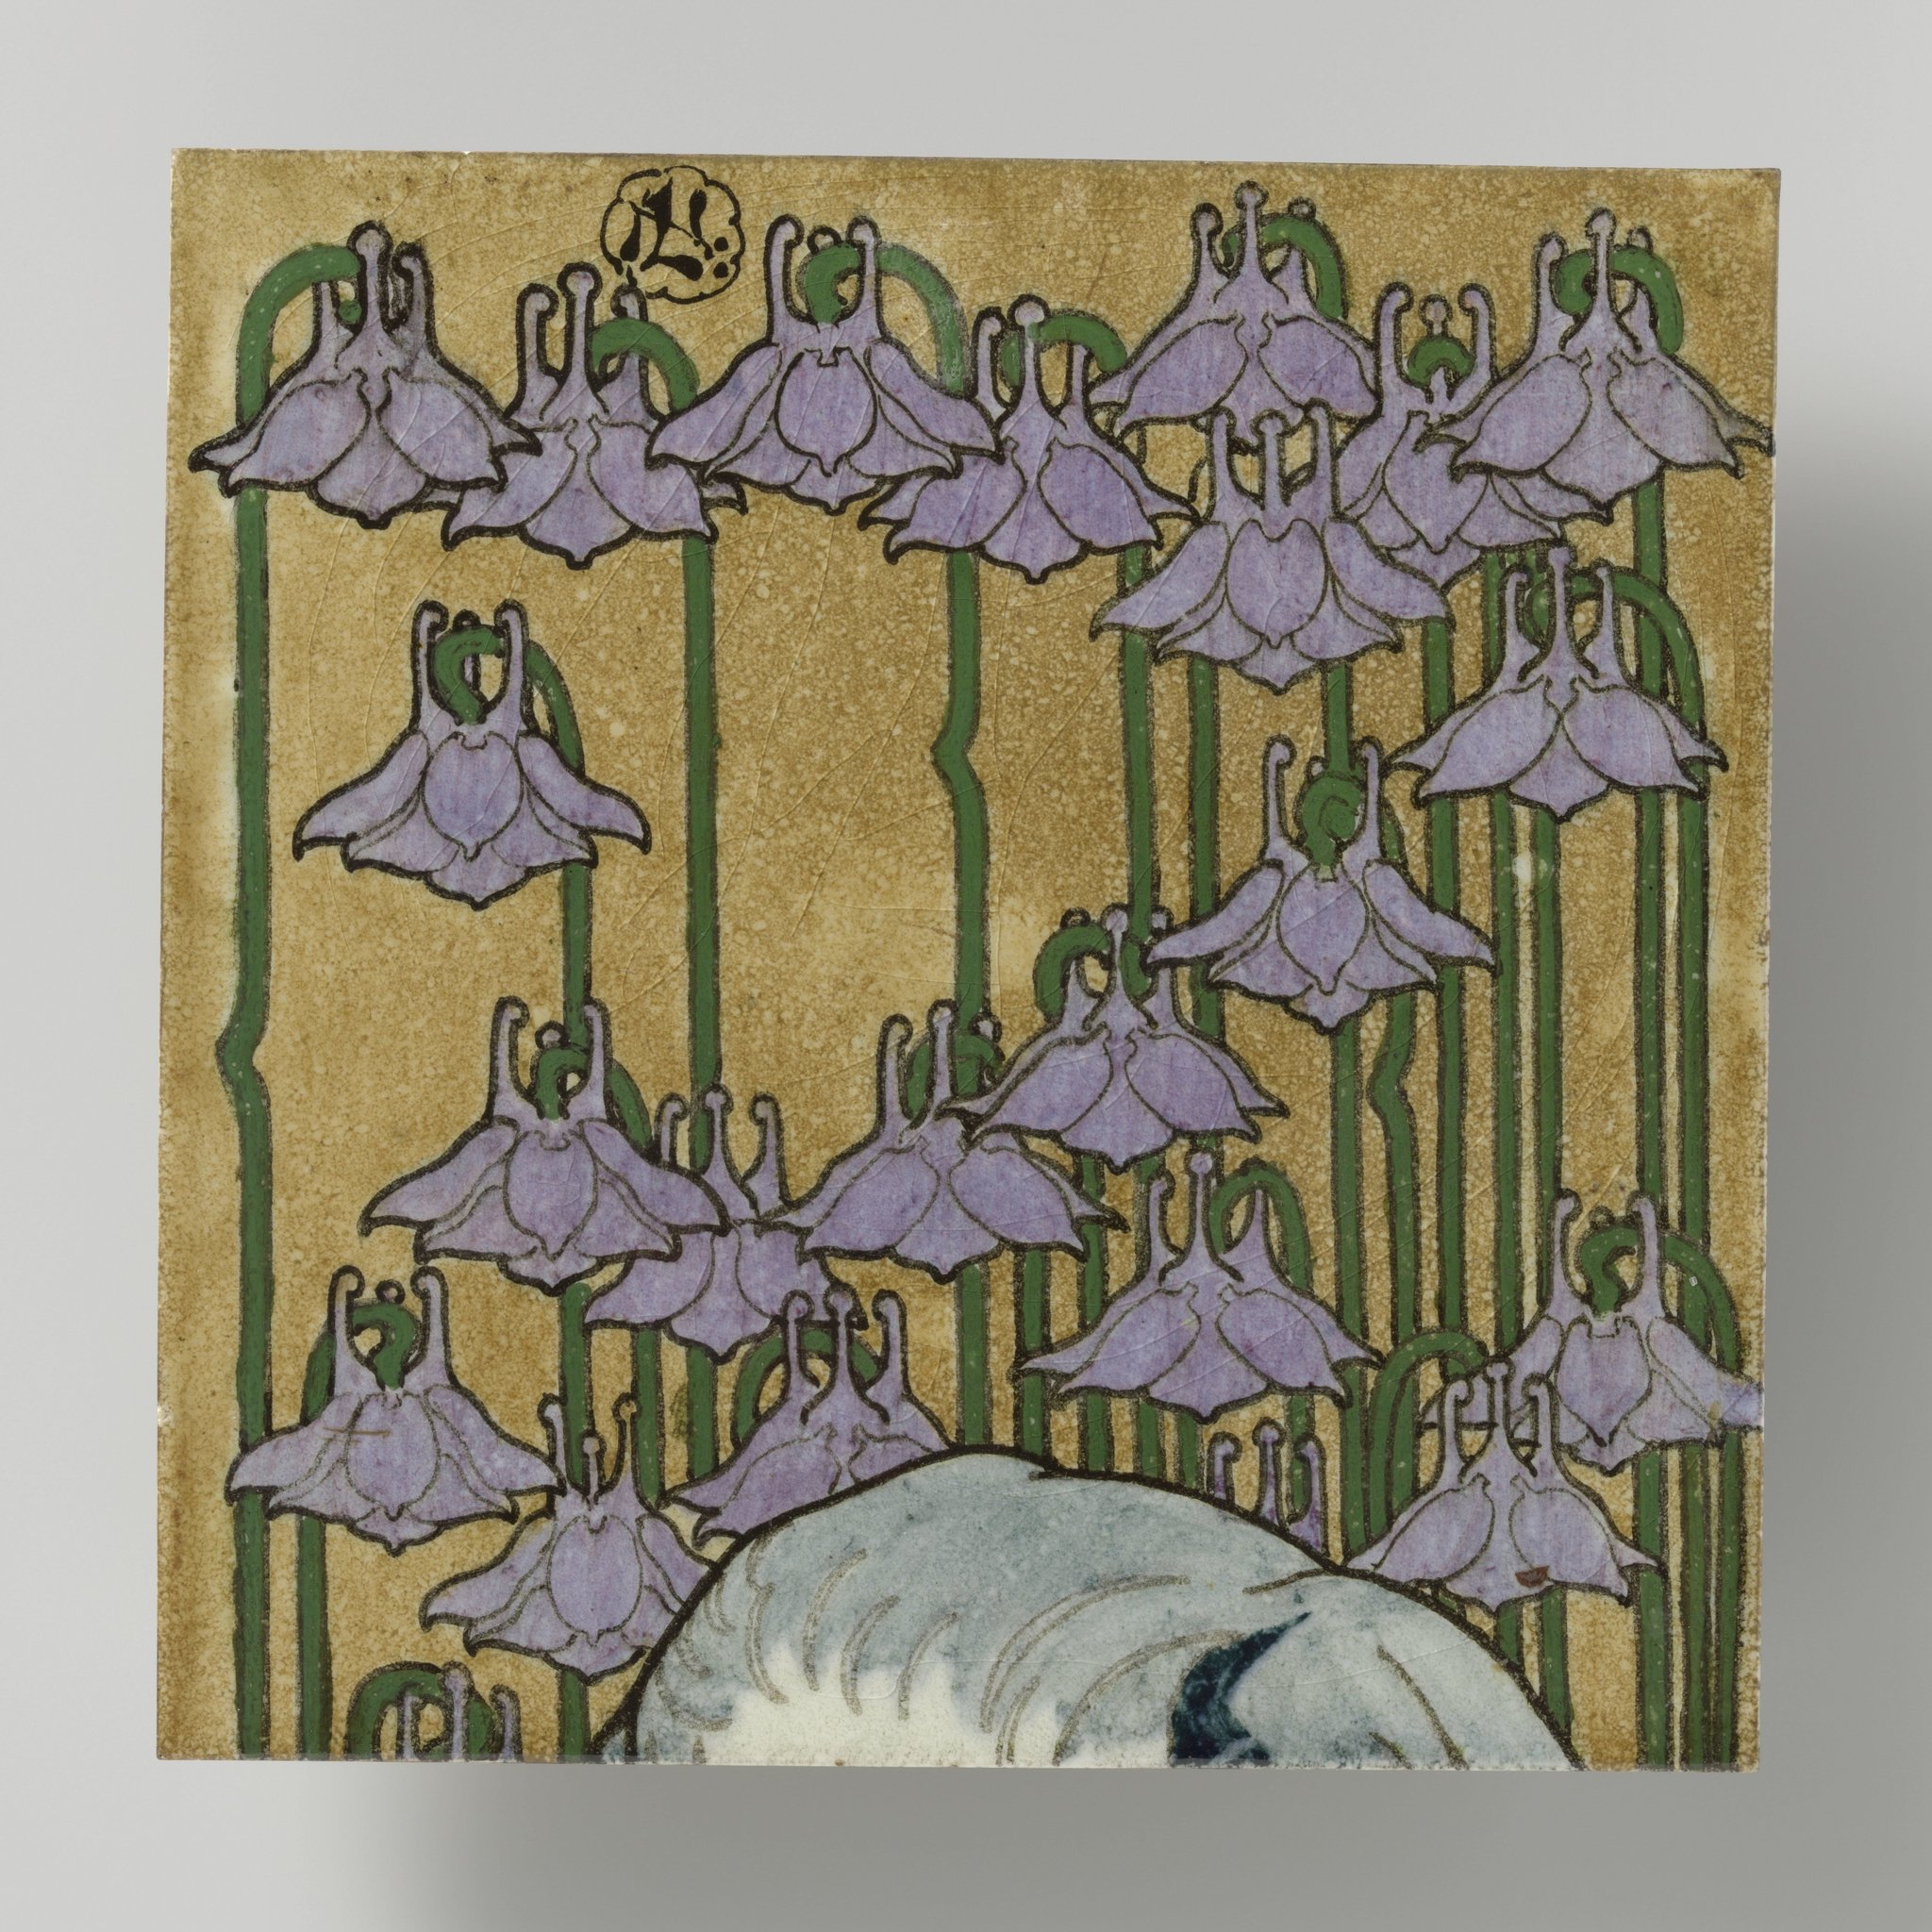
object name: tile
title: Tegel, behorend bij tegeltableau beschilderd met kraanvogels en akeleien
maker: bert nienhuis (i)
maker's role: designer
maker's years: 1873-1960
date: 1896-1901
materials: earthenware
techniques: painted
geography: amsterdam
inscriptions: monogram: ‘LN’, mark: ‘Boch Frères, La Louvière, A.’